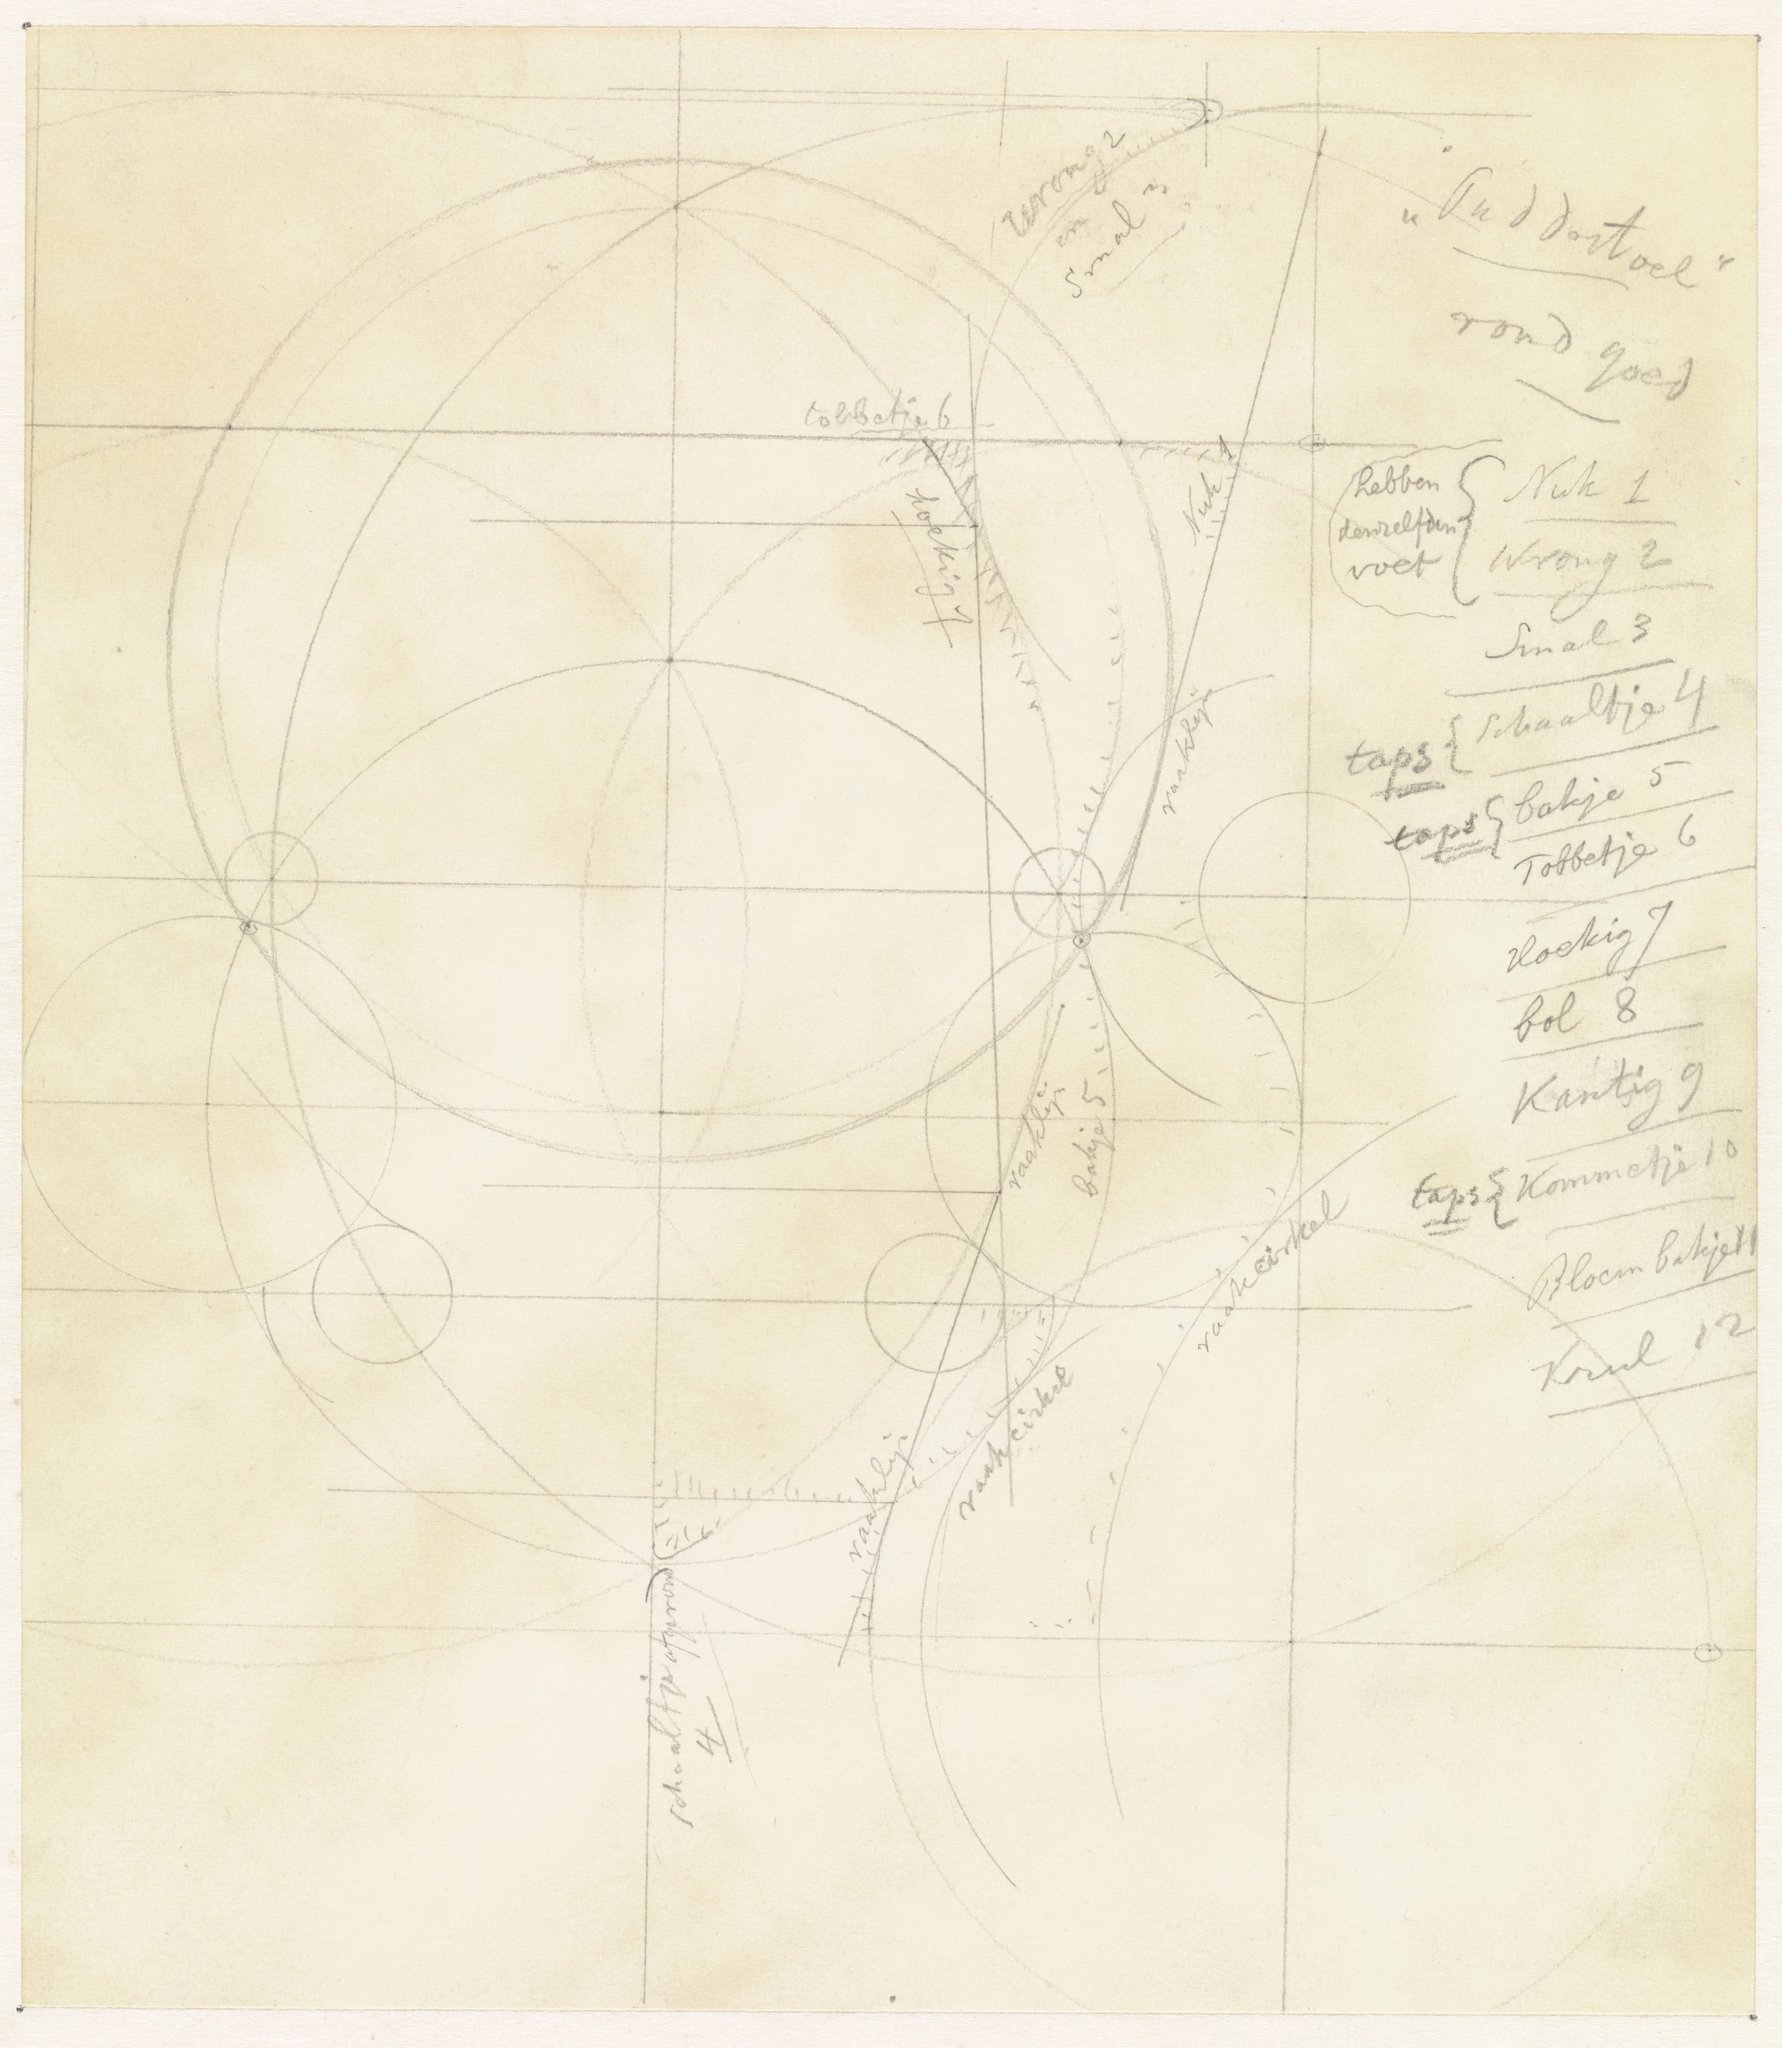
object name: drawing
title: Paddestoel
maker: theo colenbrander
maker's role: draughtsman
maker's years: 1841-1930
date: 1851-1930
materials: paper, pencil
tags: container of ceramics: jar, jug, pot, vase, laid table: table-ware, table-decoration, etc.